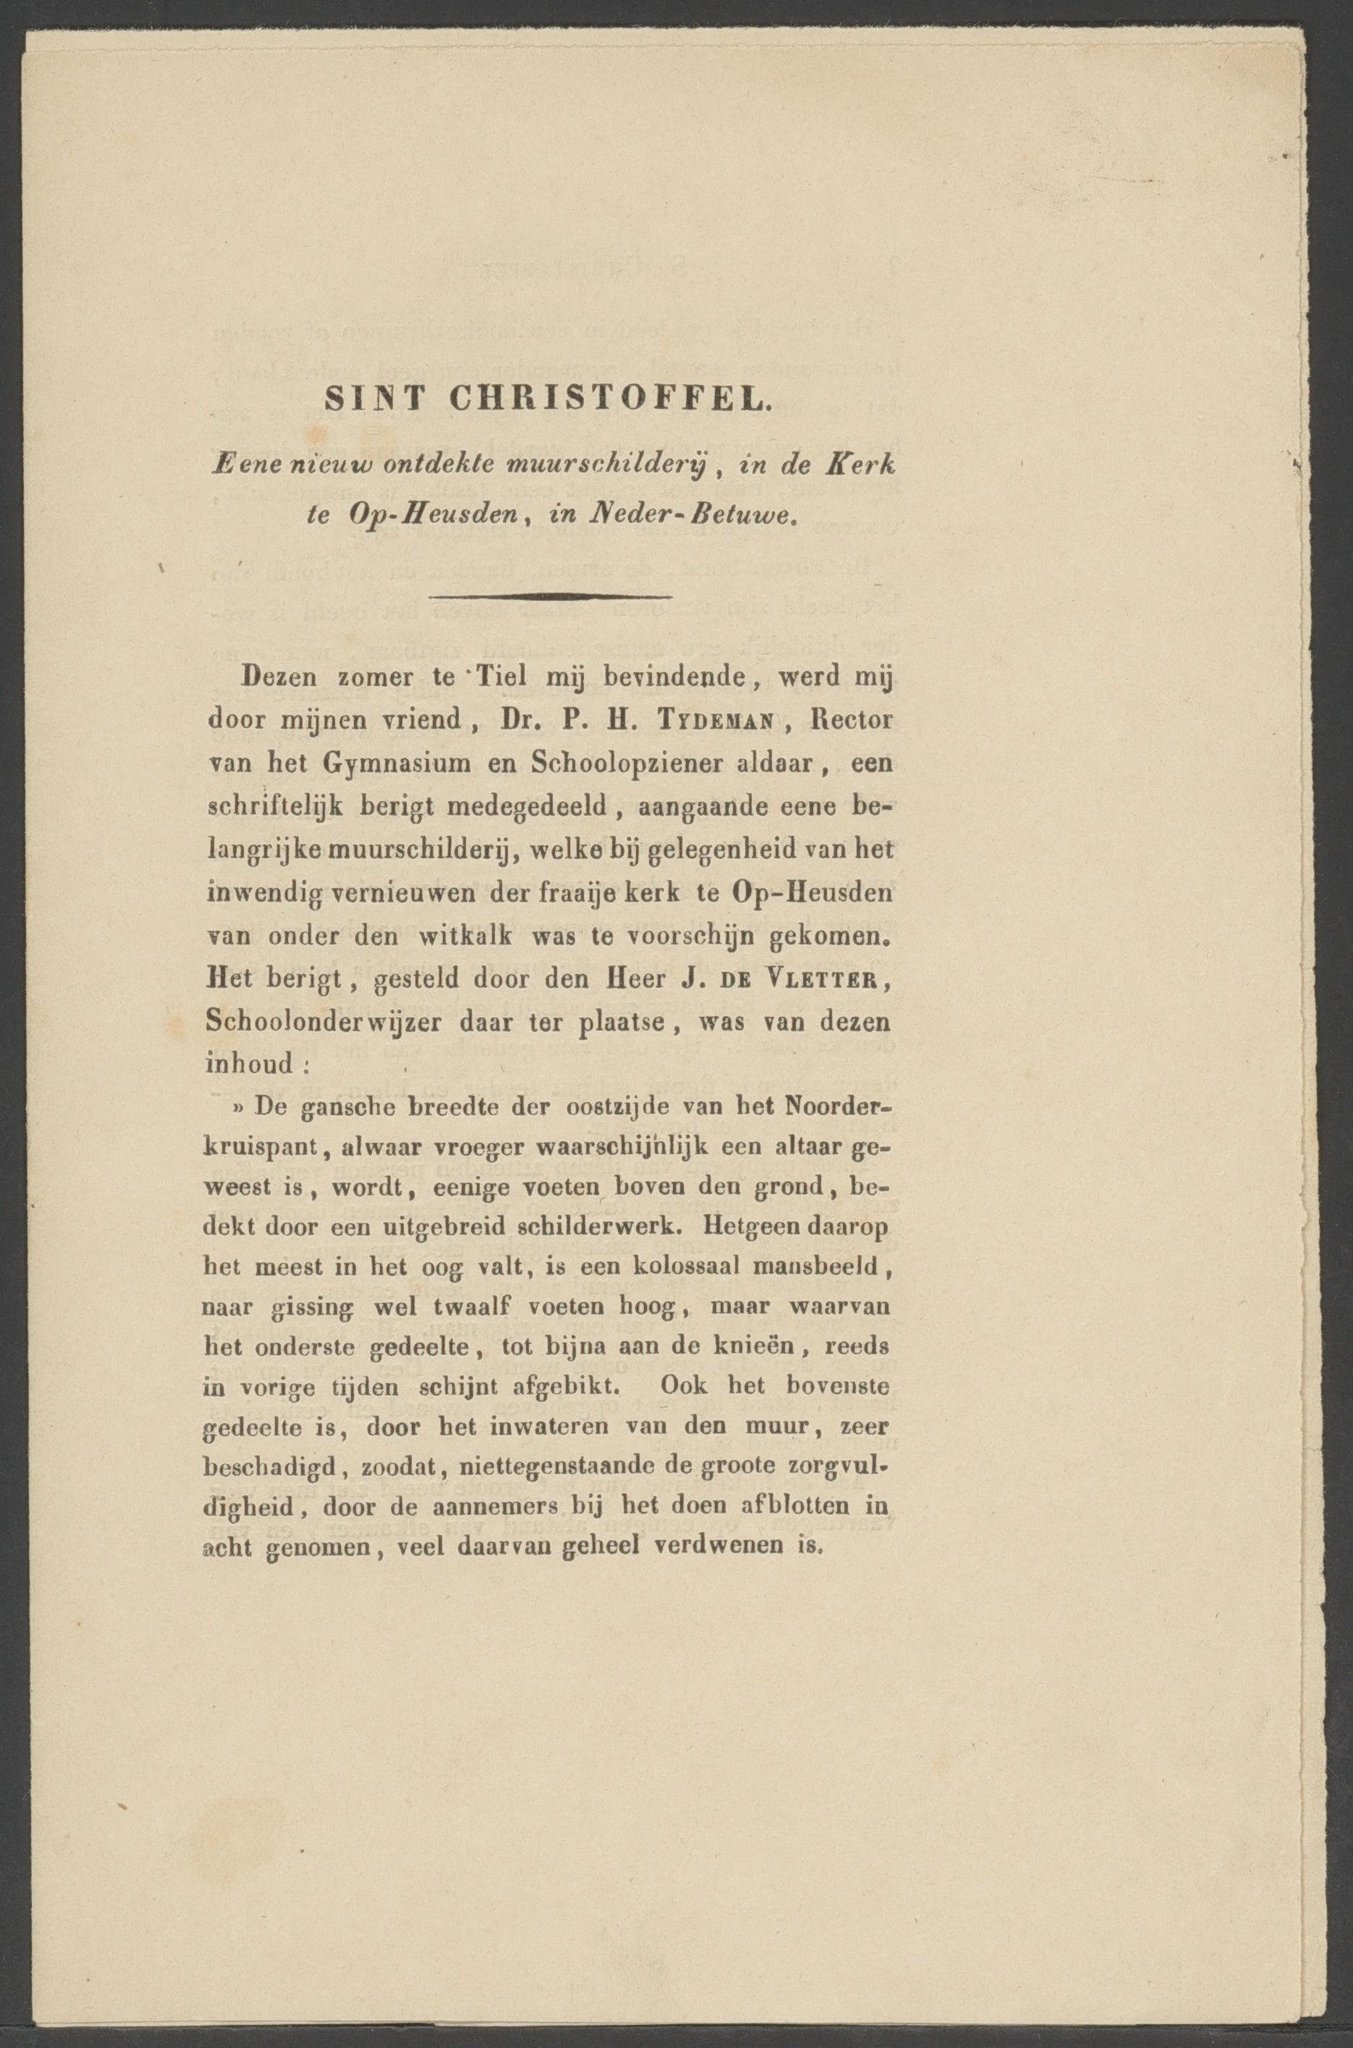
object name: text sheet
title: Sint Christoffel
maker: Anonymous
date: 1847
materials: paper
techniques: letterpress printing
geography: leiden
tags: mural painter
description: Onderwerpsrubrieken binnen de Atlas Zeden en Gewoonten: Schoone kunsten, Muur- en gewelfschilderingen.